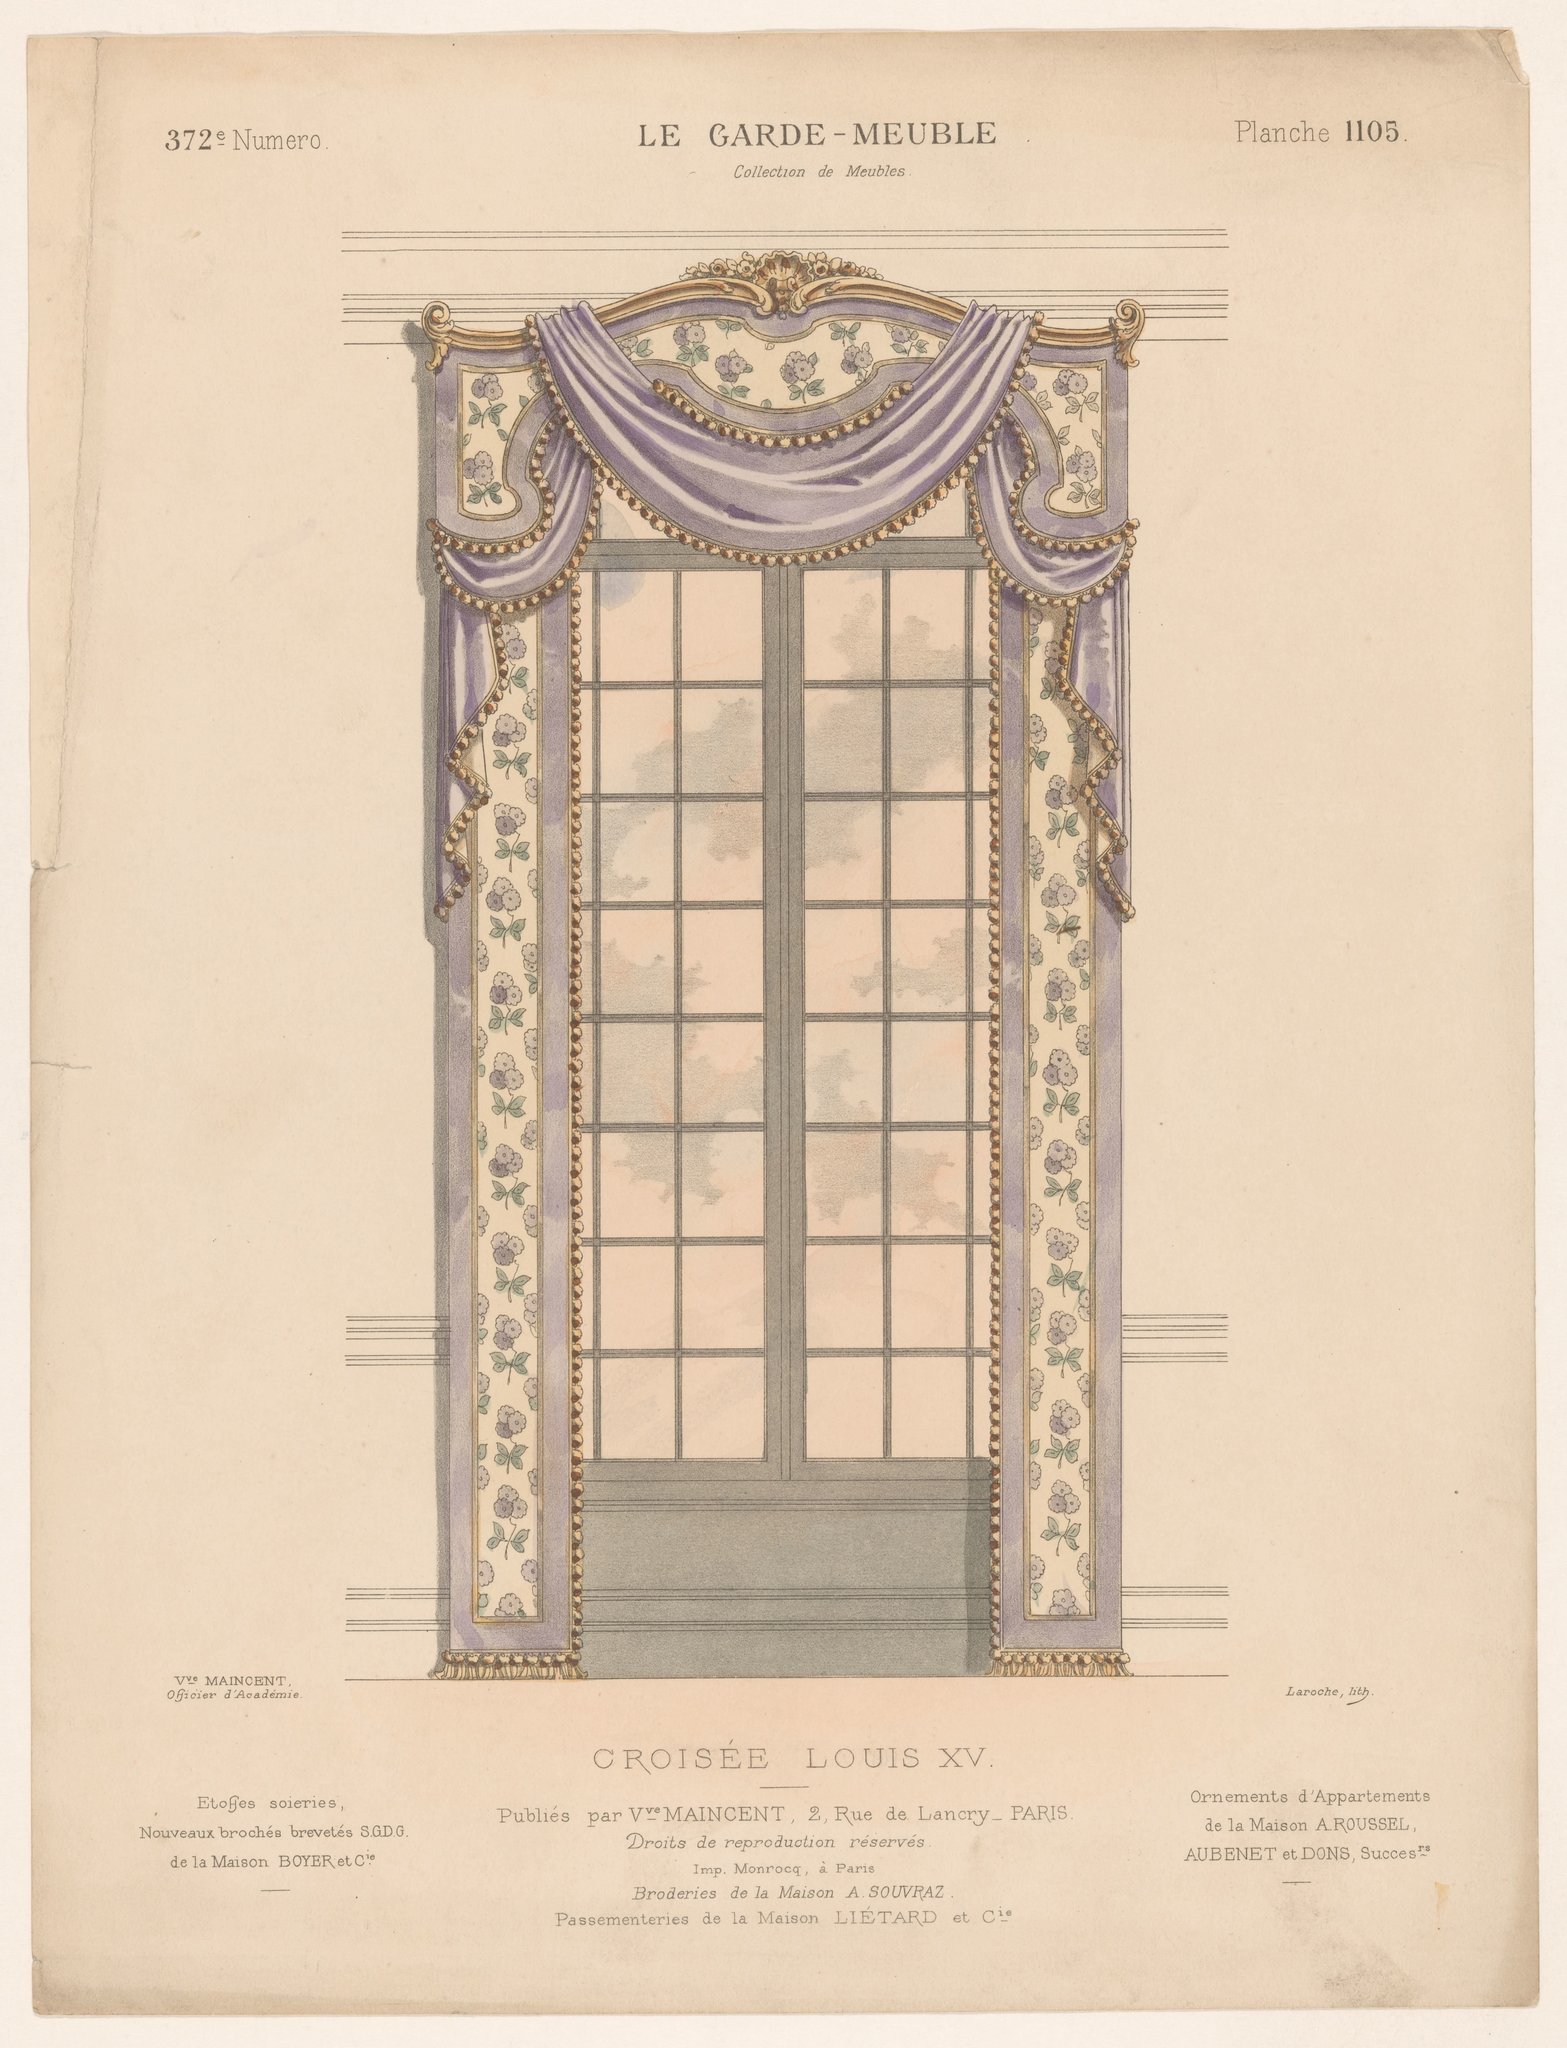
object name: print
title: Venster met gordijnen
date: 1895-1910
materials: paper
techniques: hand coloring, lithograph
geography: paris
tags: window, hangings and drapery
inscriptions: : ‘Droits de reproduction réservés.’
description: Kruisvenster met gedrapeerde gordijnen in de Lodewijk XV-stijl. Prent uit 372e Livraison.